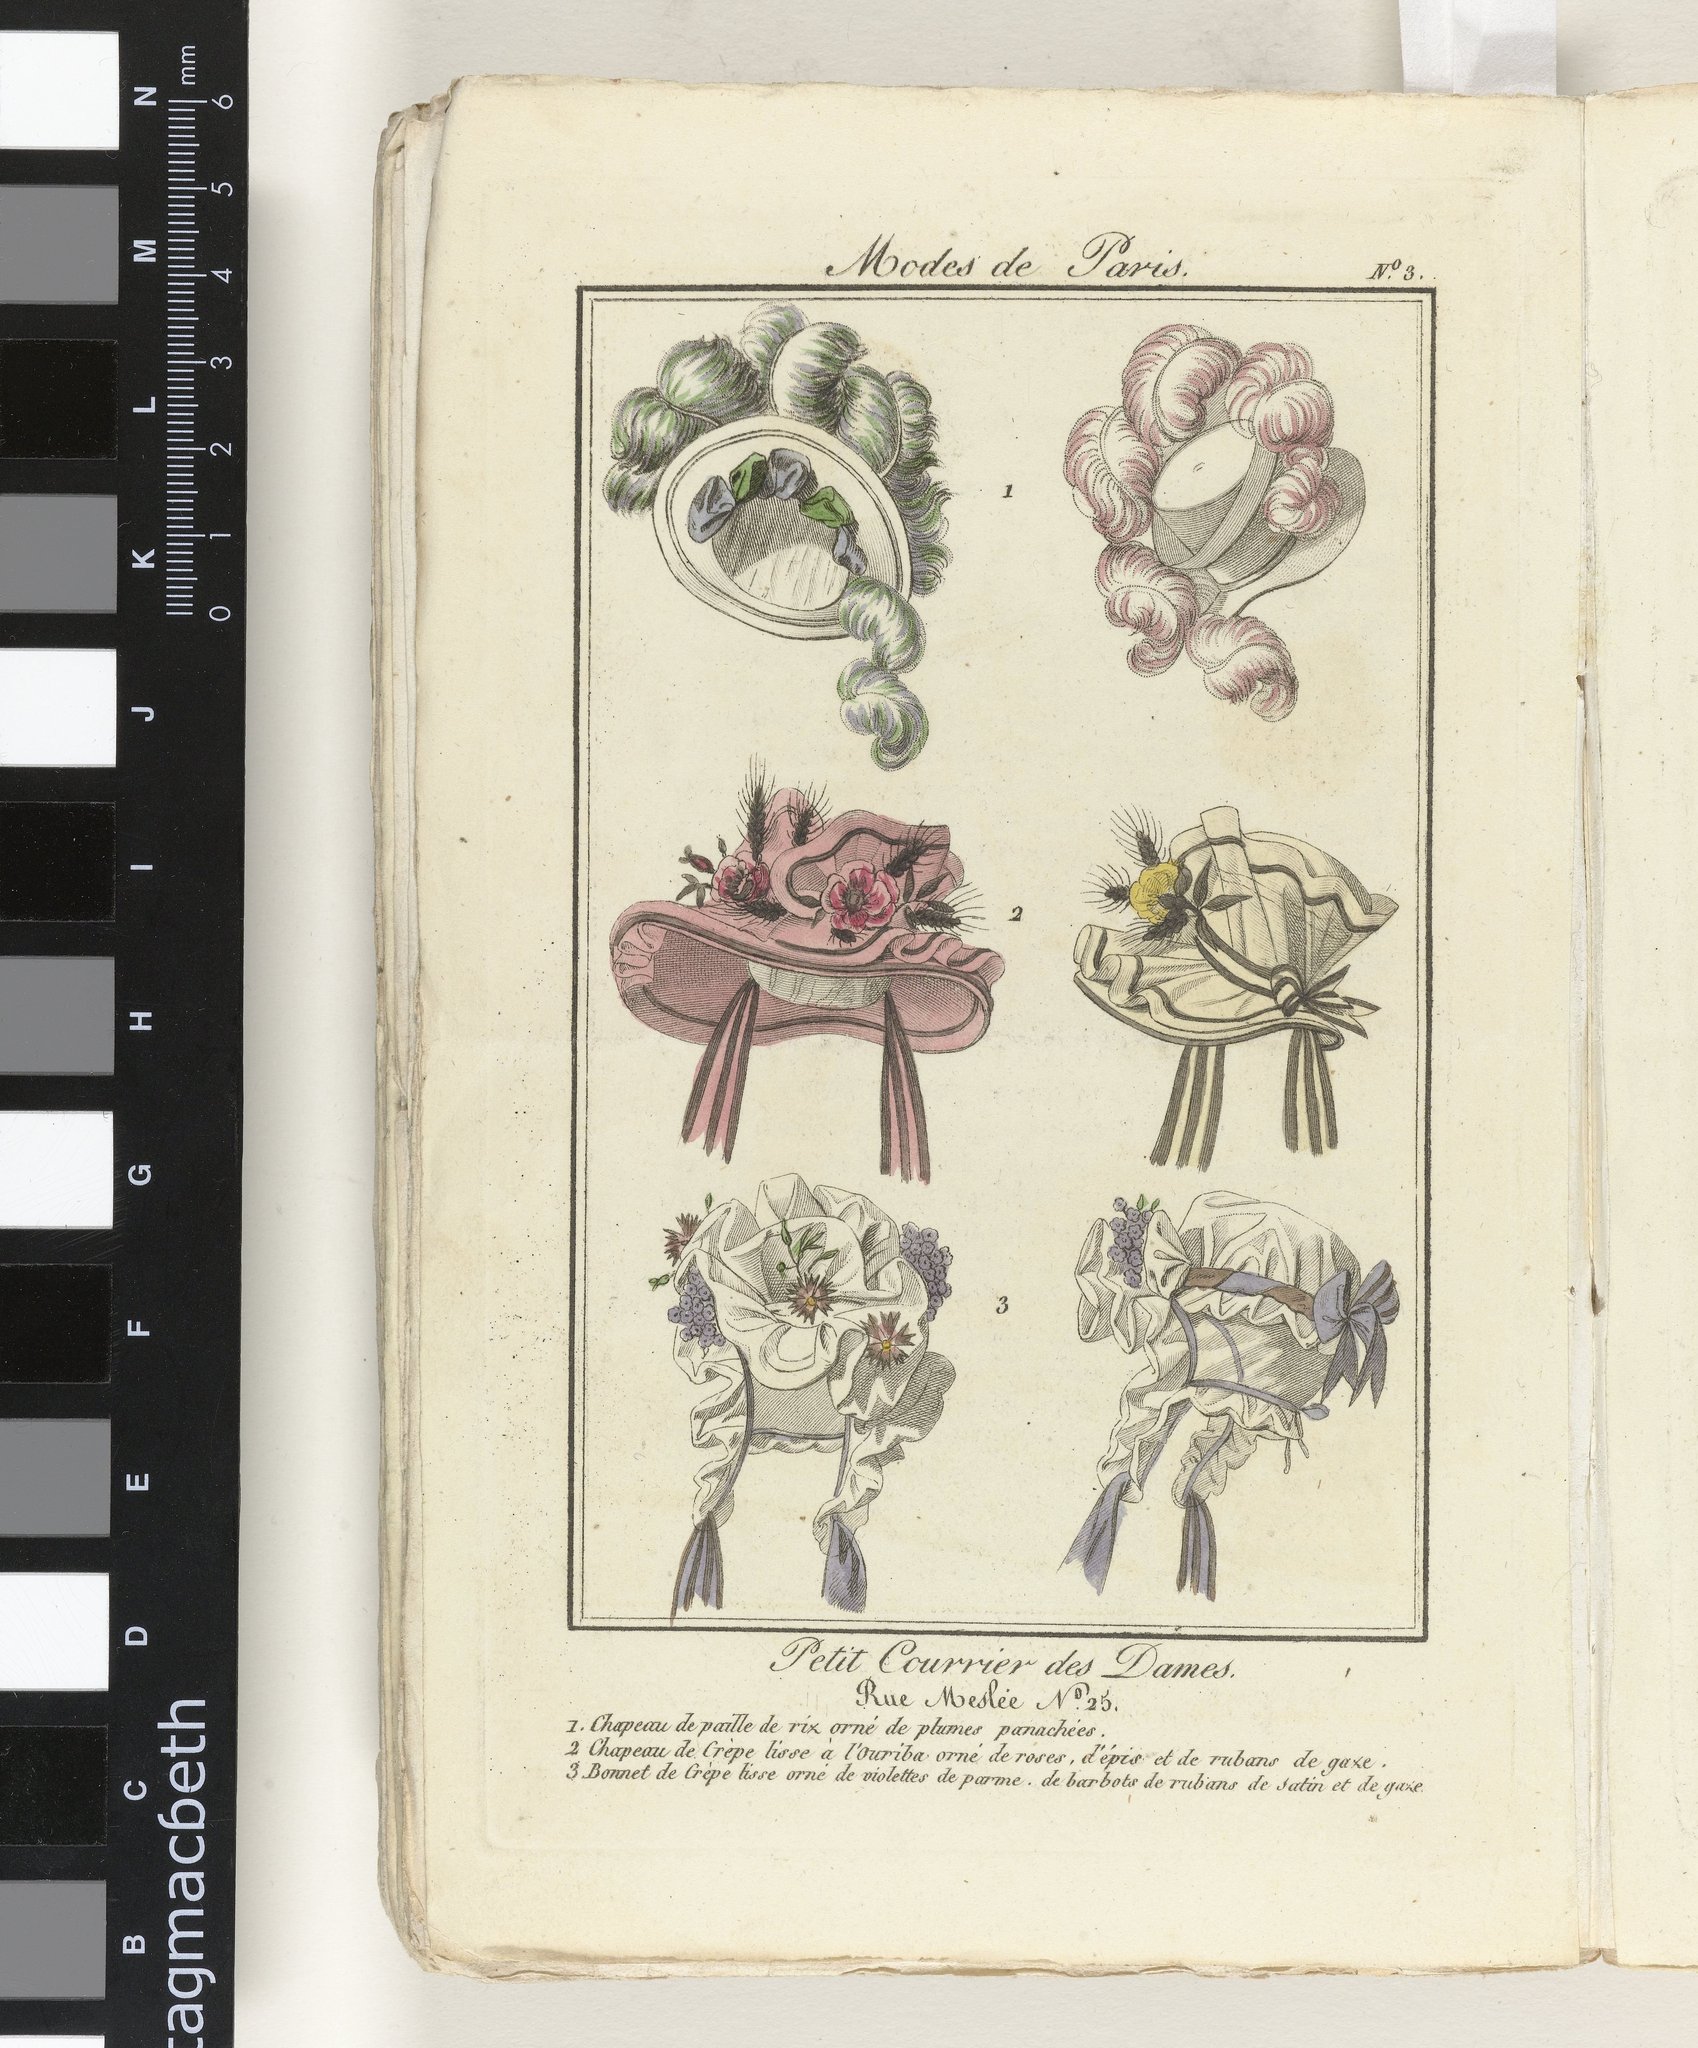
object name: fashion print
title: Petit Courrier des Dames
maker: Anonymous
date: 1823-1830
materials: paper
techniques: engraving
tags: fashion plates